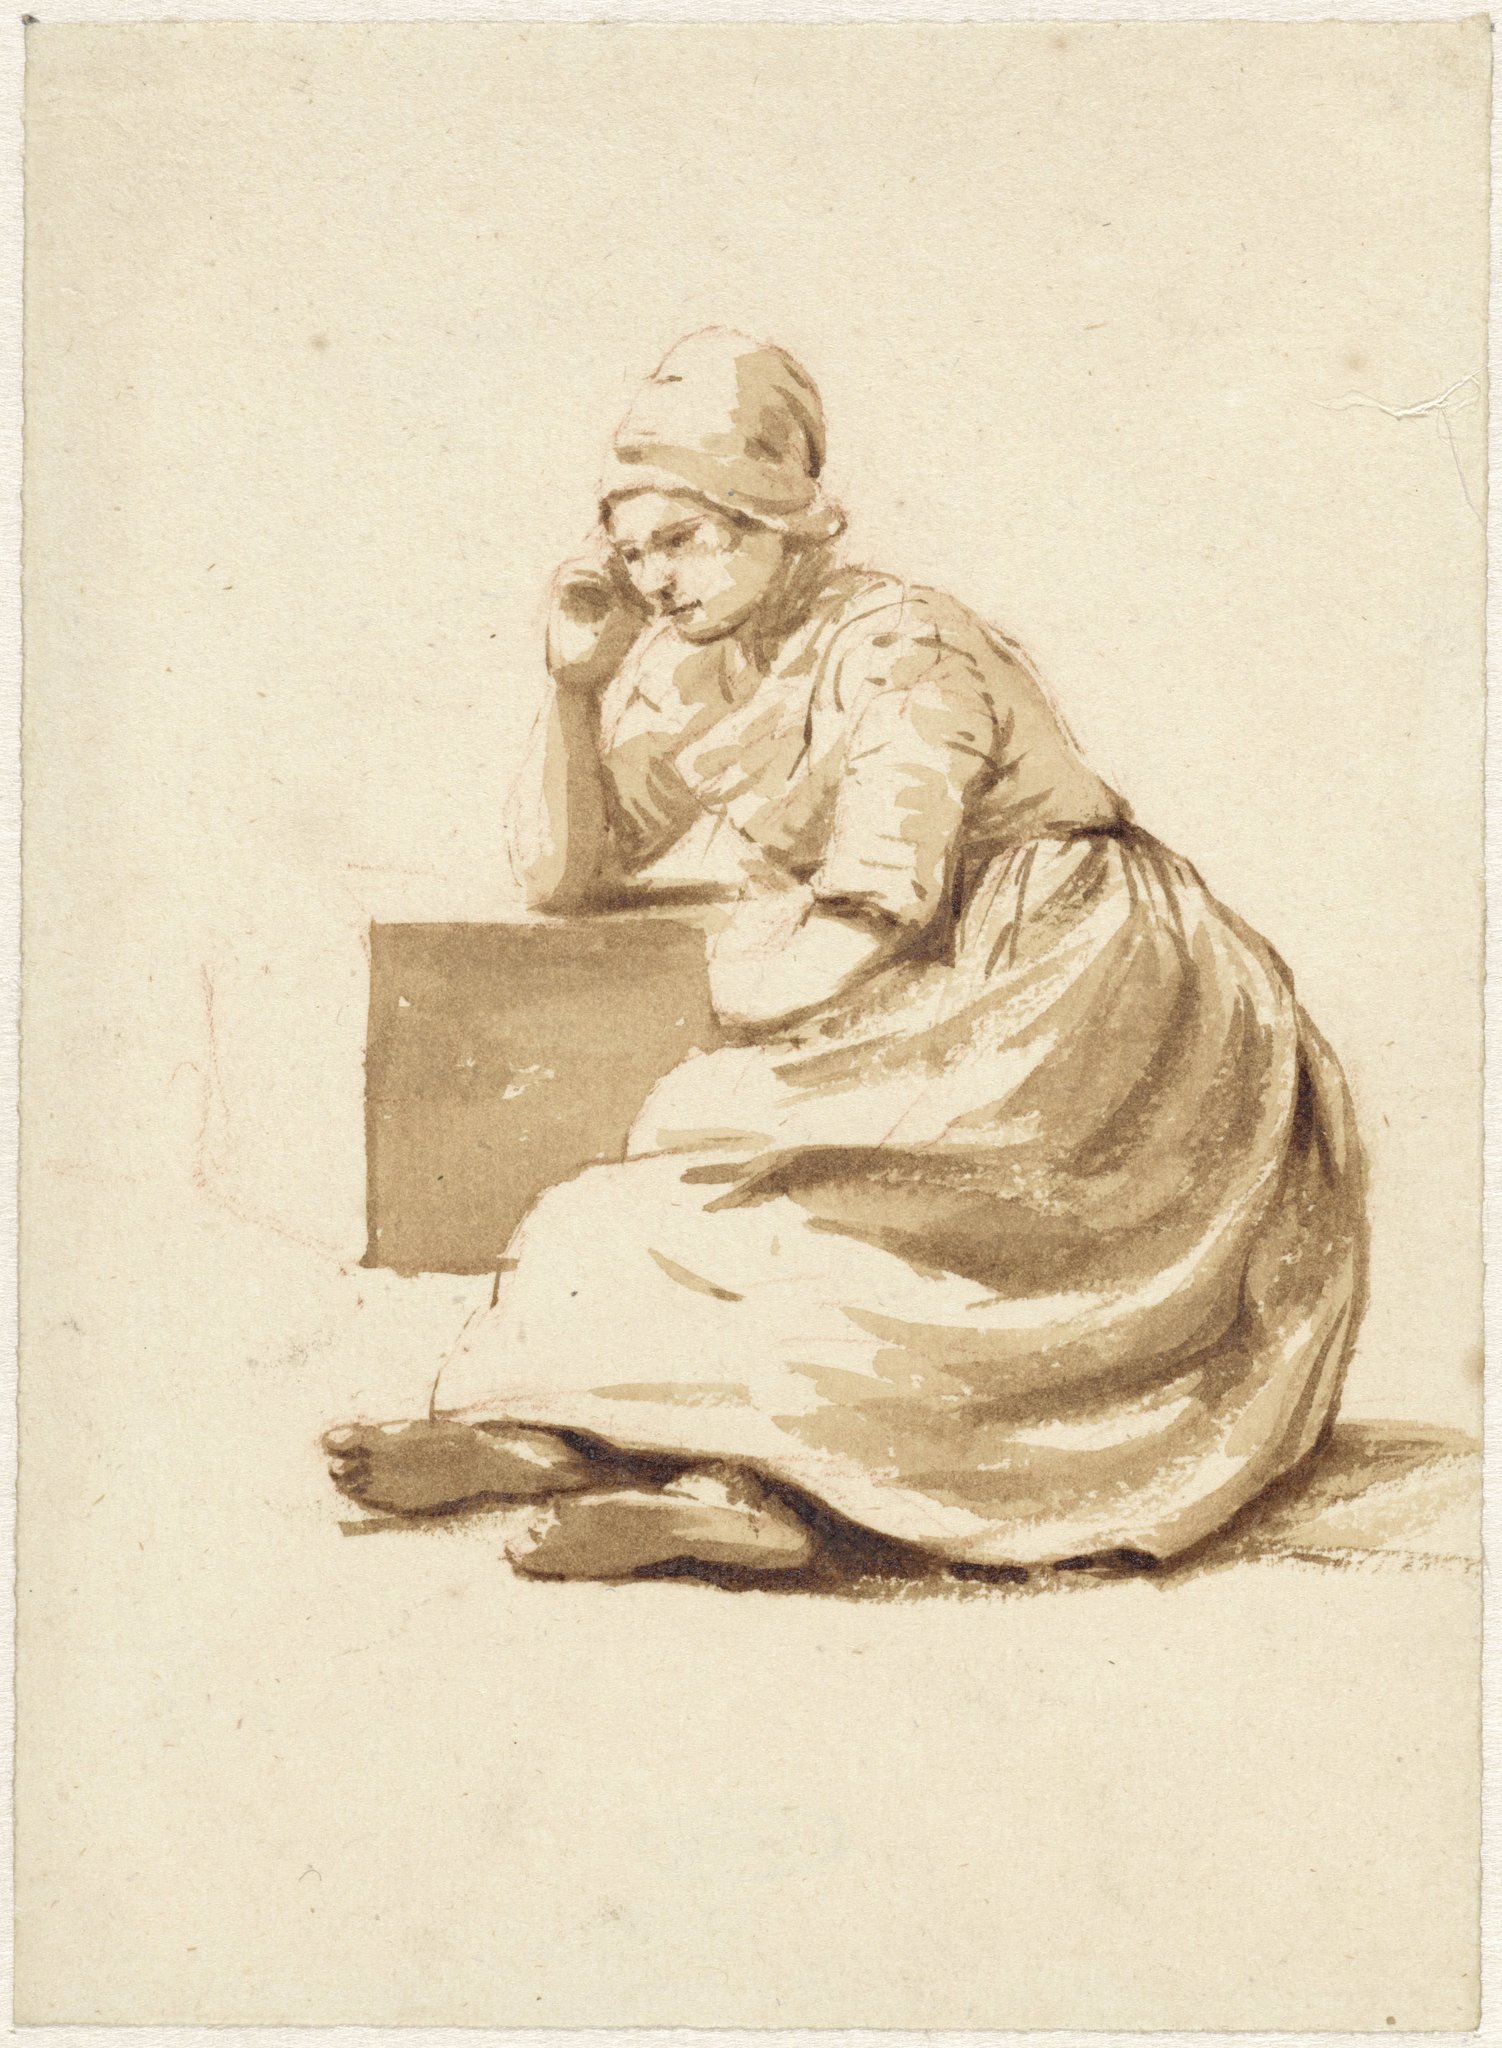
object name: drawing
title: Zittende vrouw, steunend op een blok steen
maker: pieter ernst hendrik praetorius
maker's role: draughtsman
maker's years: 1791-1876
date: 1801-1876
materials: chalk, paper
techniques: brush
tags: sitting figure, female sex; woman